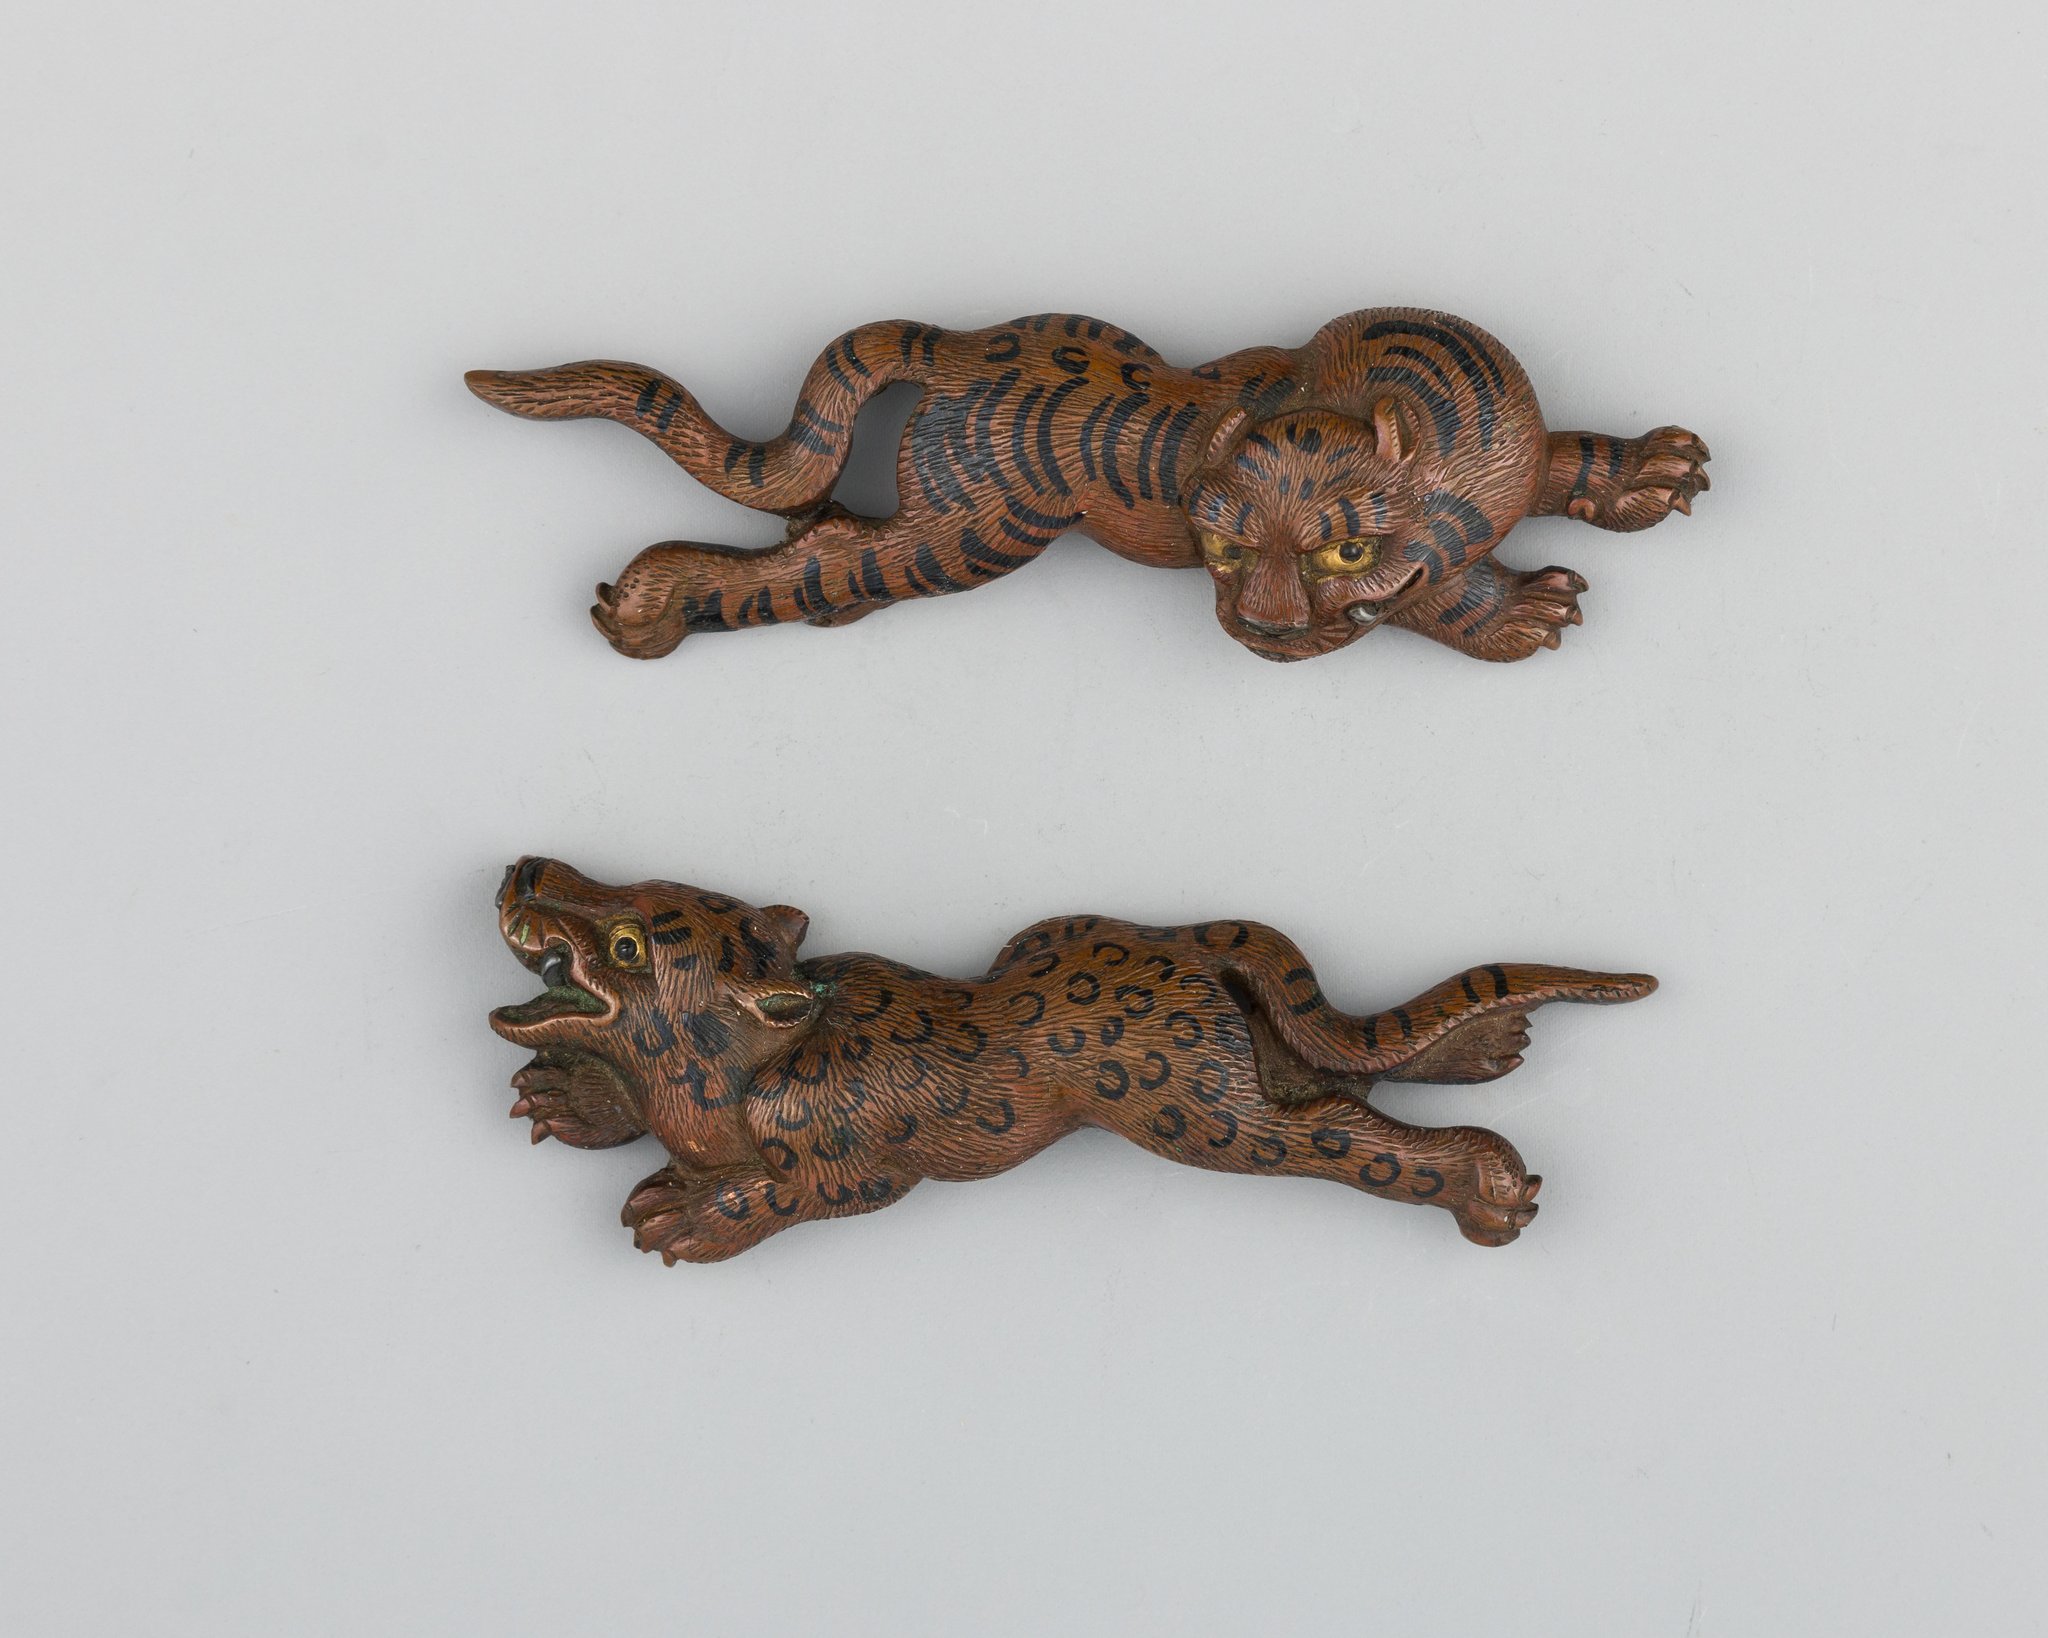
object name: pair of sword grip ornament menuki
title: Pair of Sword-Grip Ornaments (Menuki)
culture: japanese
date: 1801-1900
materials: copper, gold alloy, gold, silver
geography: japan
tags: animals